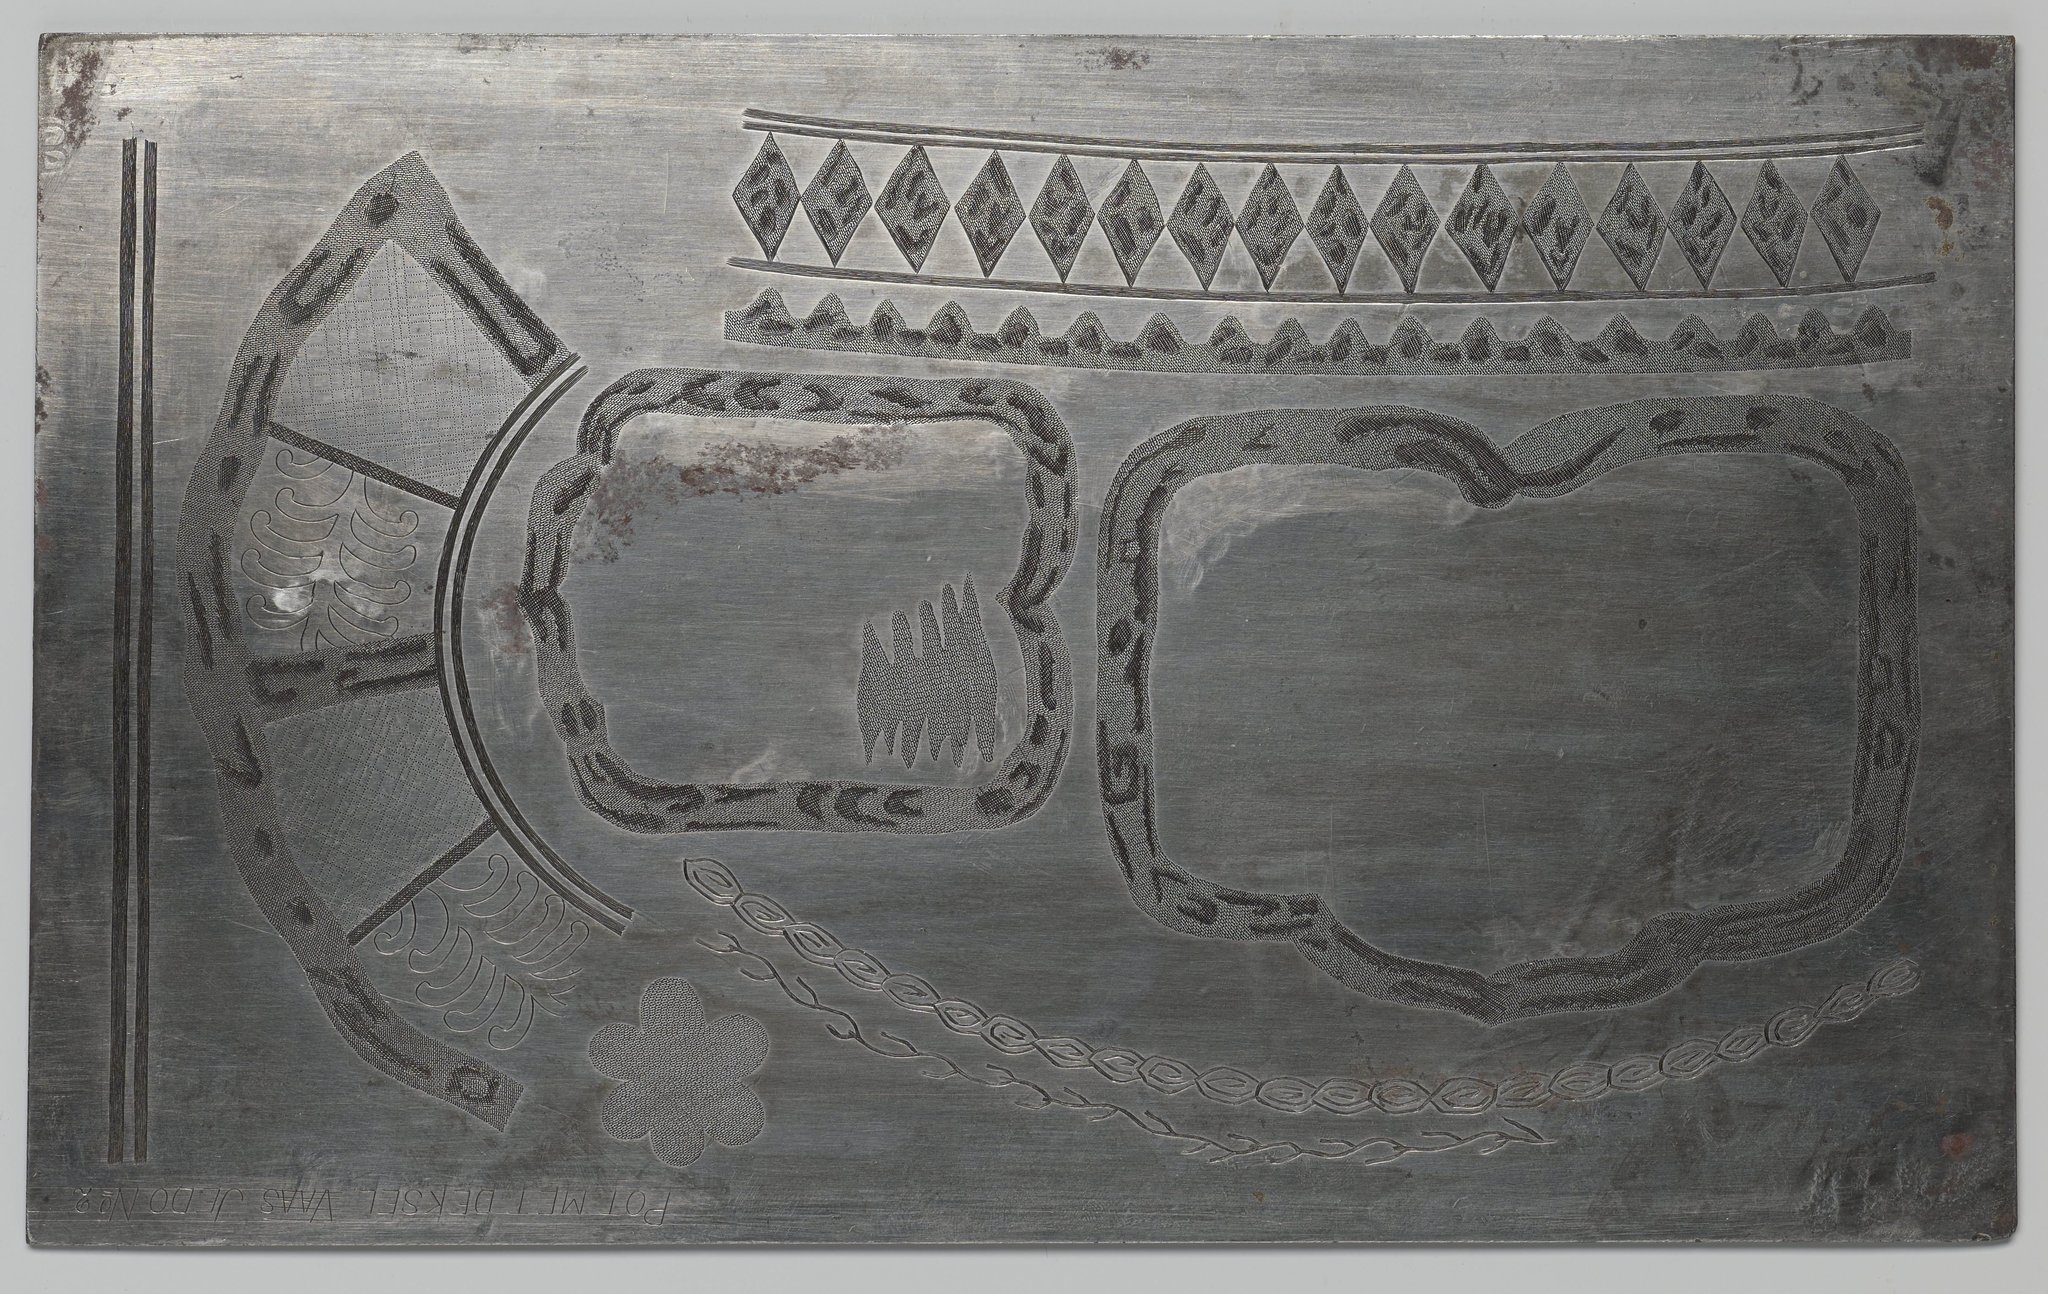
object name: plate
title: Plaat met gegraveerde decoraties voor aardewerk met randdecoraties voor borden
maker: petrus regout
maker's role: plateelbakker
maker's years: 1801-1879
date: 1801-1879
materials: copper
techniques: engraving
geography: maastricht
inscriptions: inscription: ‘RAND ... (?)’, inscription: ‘KOMM ... N’, inscription: ‘1221’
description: Plaat van koper met gegraveerde voorstellingen. Aan de ene kant drie randdecoraties voor borden met zeshoekige velden met bloemen en een fragment van een decor met spelende kinderen (sluit aan op: BK-1983-299). In de rechter bovenhoek de tekst: KOMM ... N. In de linker bovenhoek het nummer: 1221. De andere zijde met drie gegraveerde randdecoraties voor borden met bloemen. In de rechter bovenhoek de tekst: RAND ... (?).